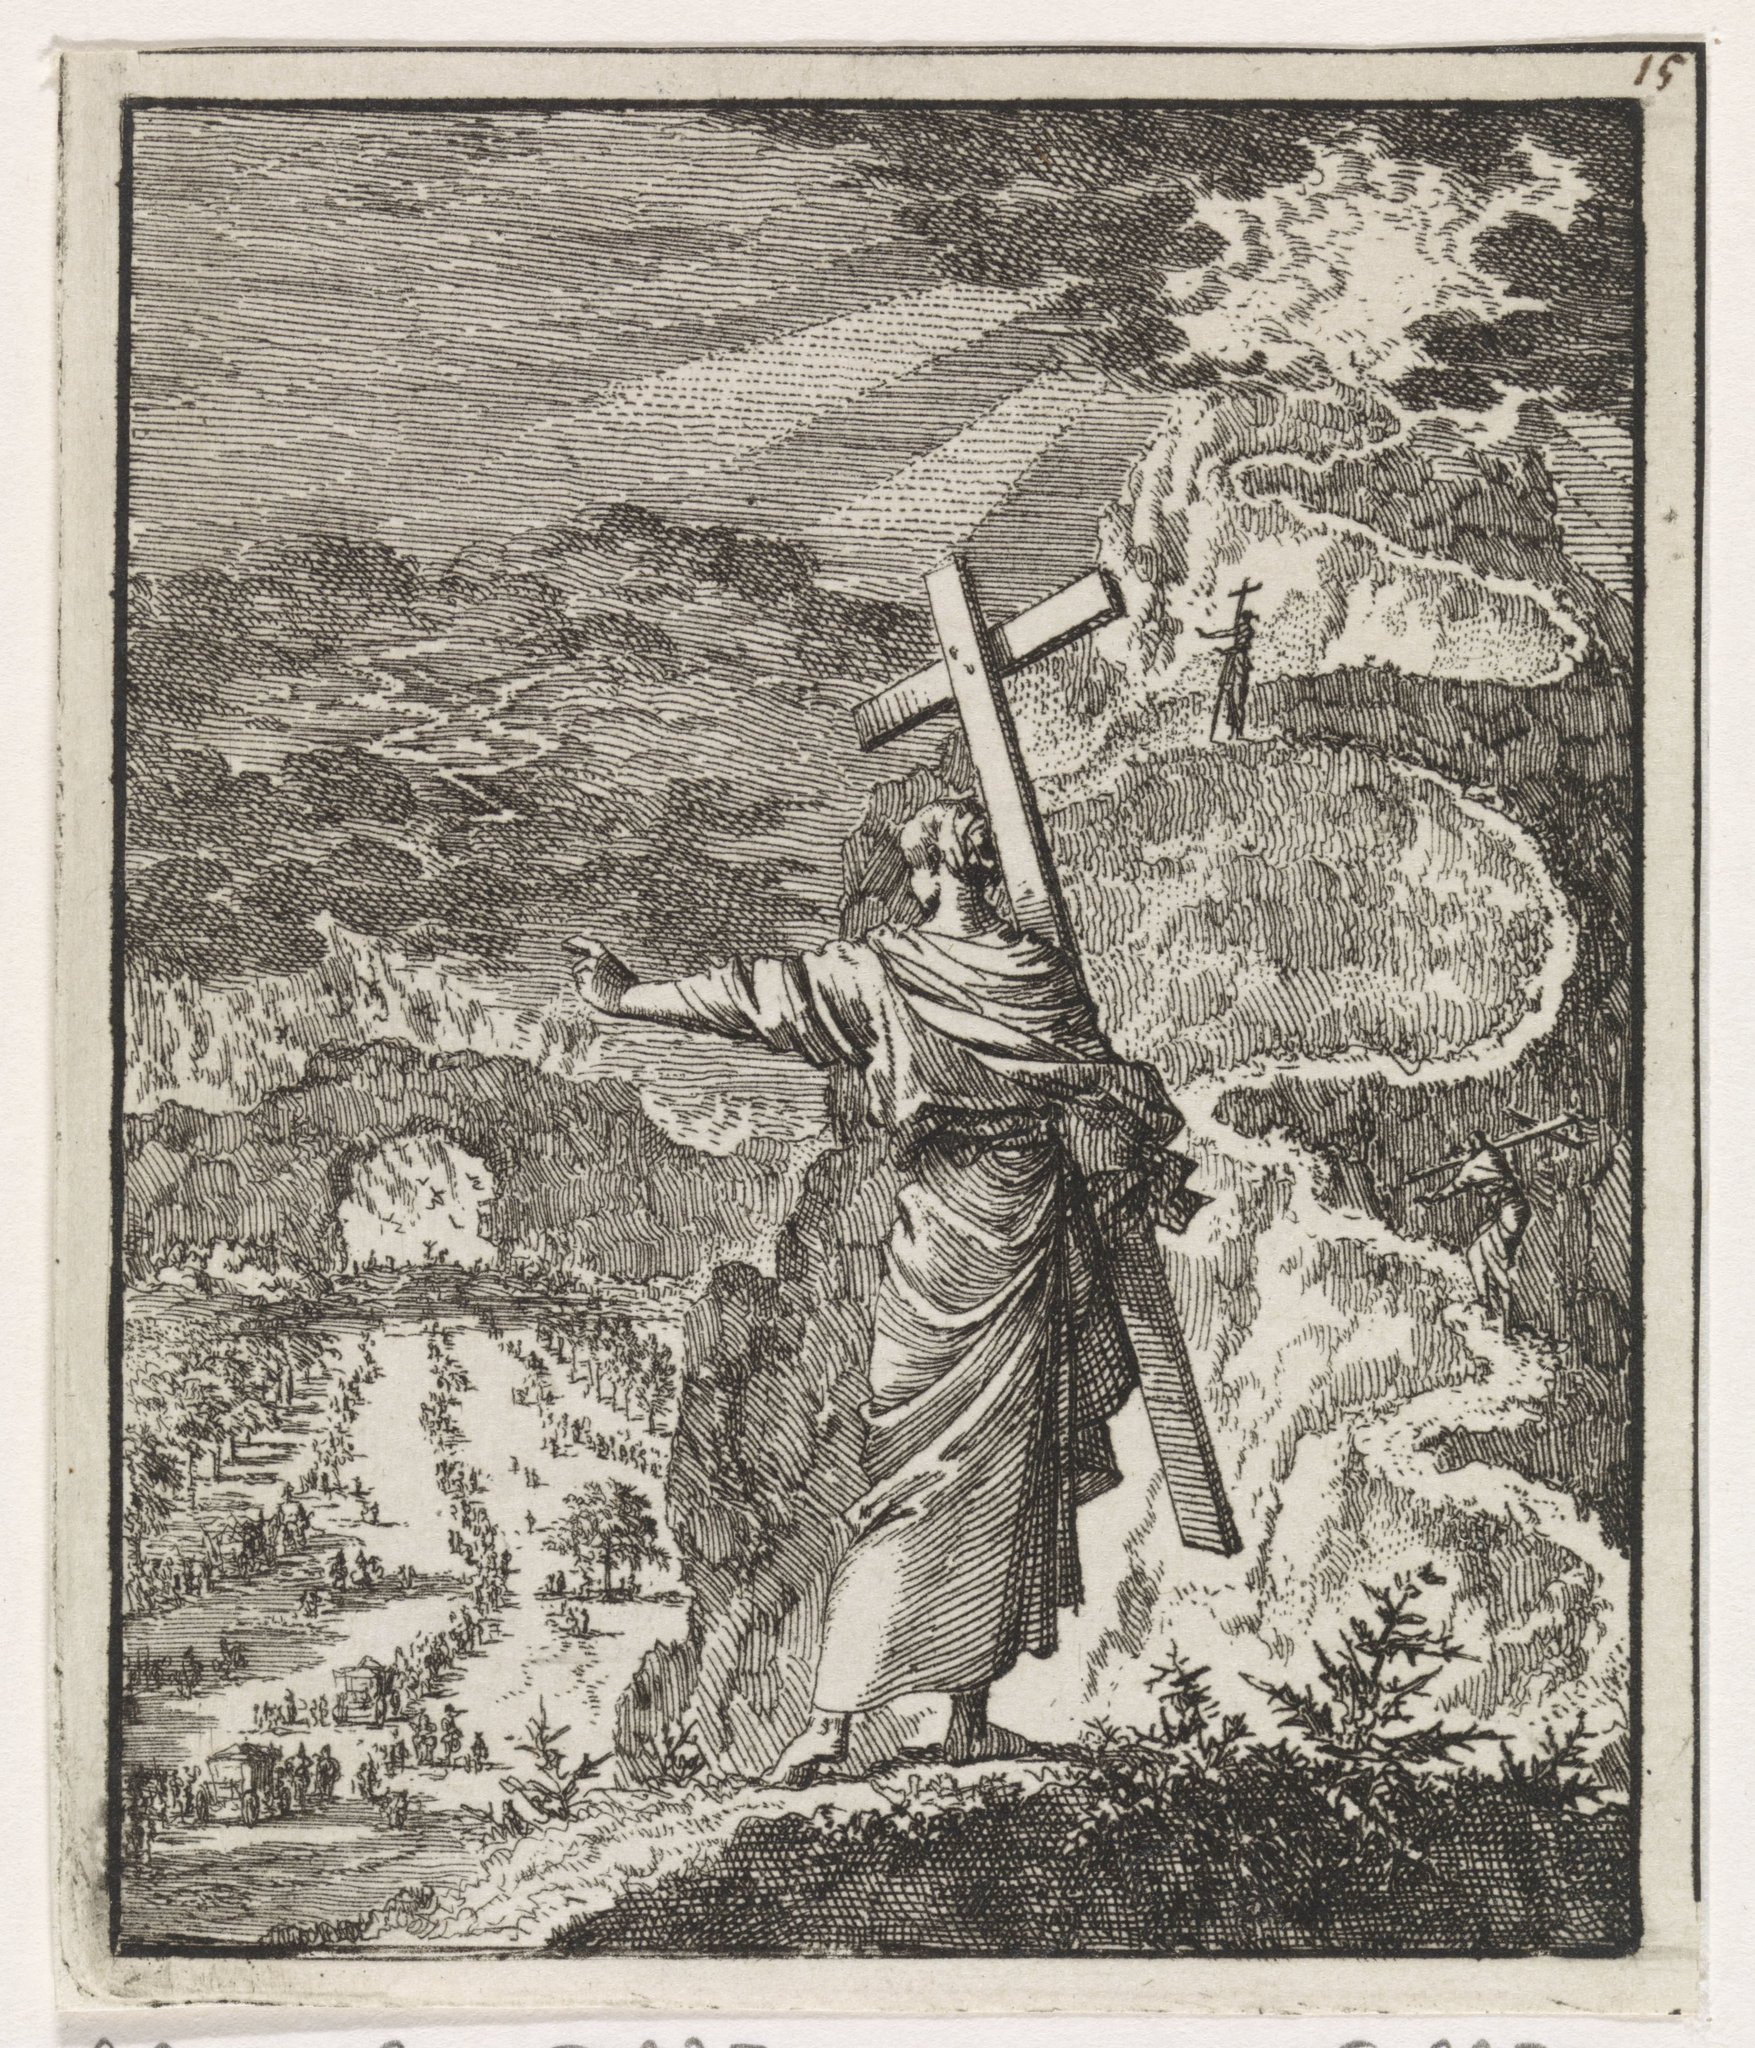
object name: print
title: Vrouw met kruis kijkt vanaf de smalle weg naar de vele figuren op de brede weg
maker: jan luyken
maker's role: draughtsman, print maker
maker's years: 1649-1712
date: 1704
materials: paper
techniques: etching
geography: amsterdam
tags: the narrow way ~ doctrine of christ on love, etc., journey to heaven, pathway to heaven, the broad way ~ doctrine of christ on love, etc.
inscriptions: collector's mark: Lugt 2228, number: ‘15’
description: Proefdruk van illustratie uit: Luyken, Jan. De zedelyke en stichtelyke gezangen. Amsterdam: Wed. Pieter Arentsz (II) en Cornelis van der Sys, 1704, p. 131.